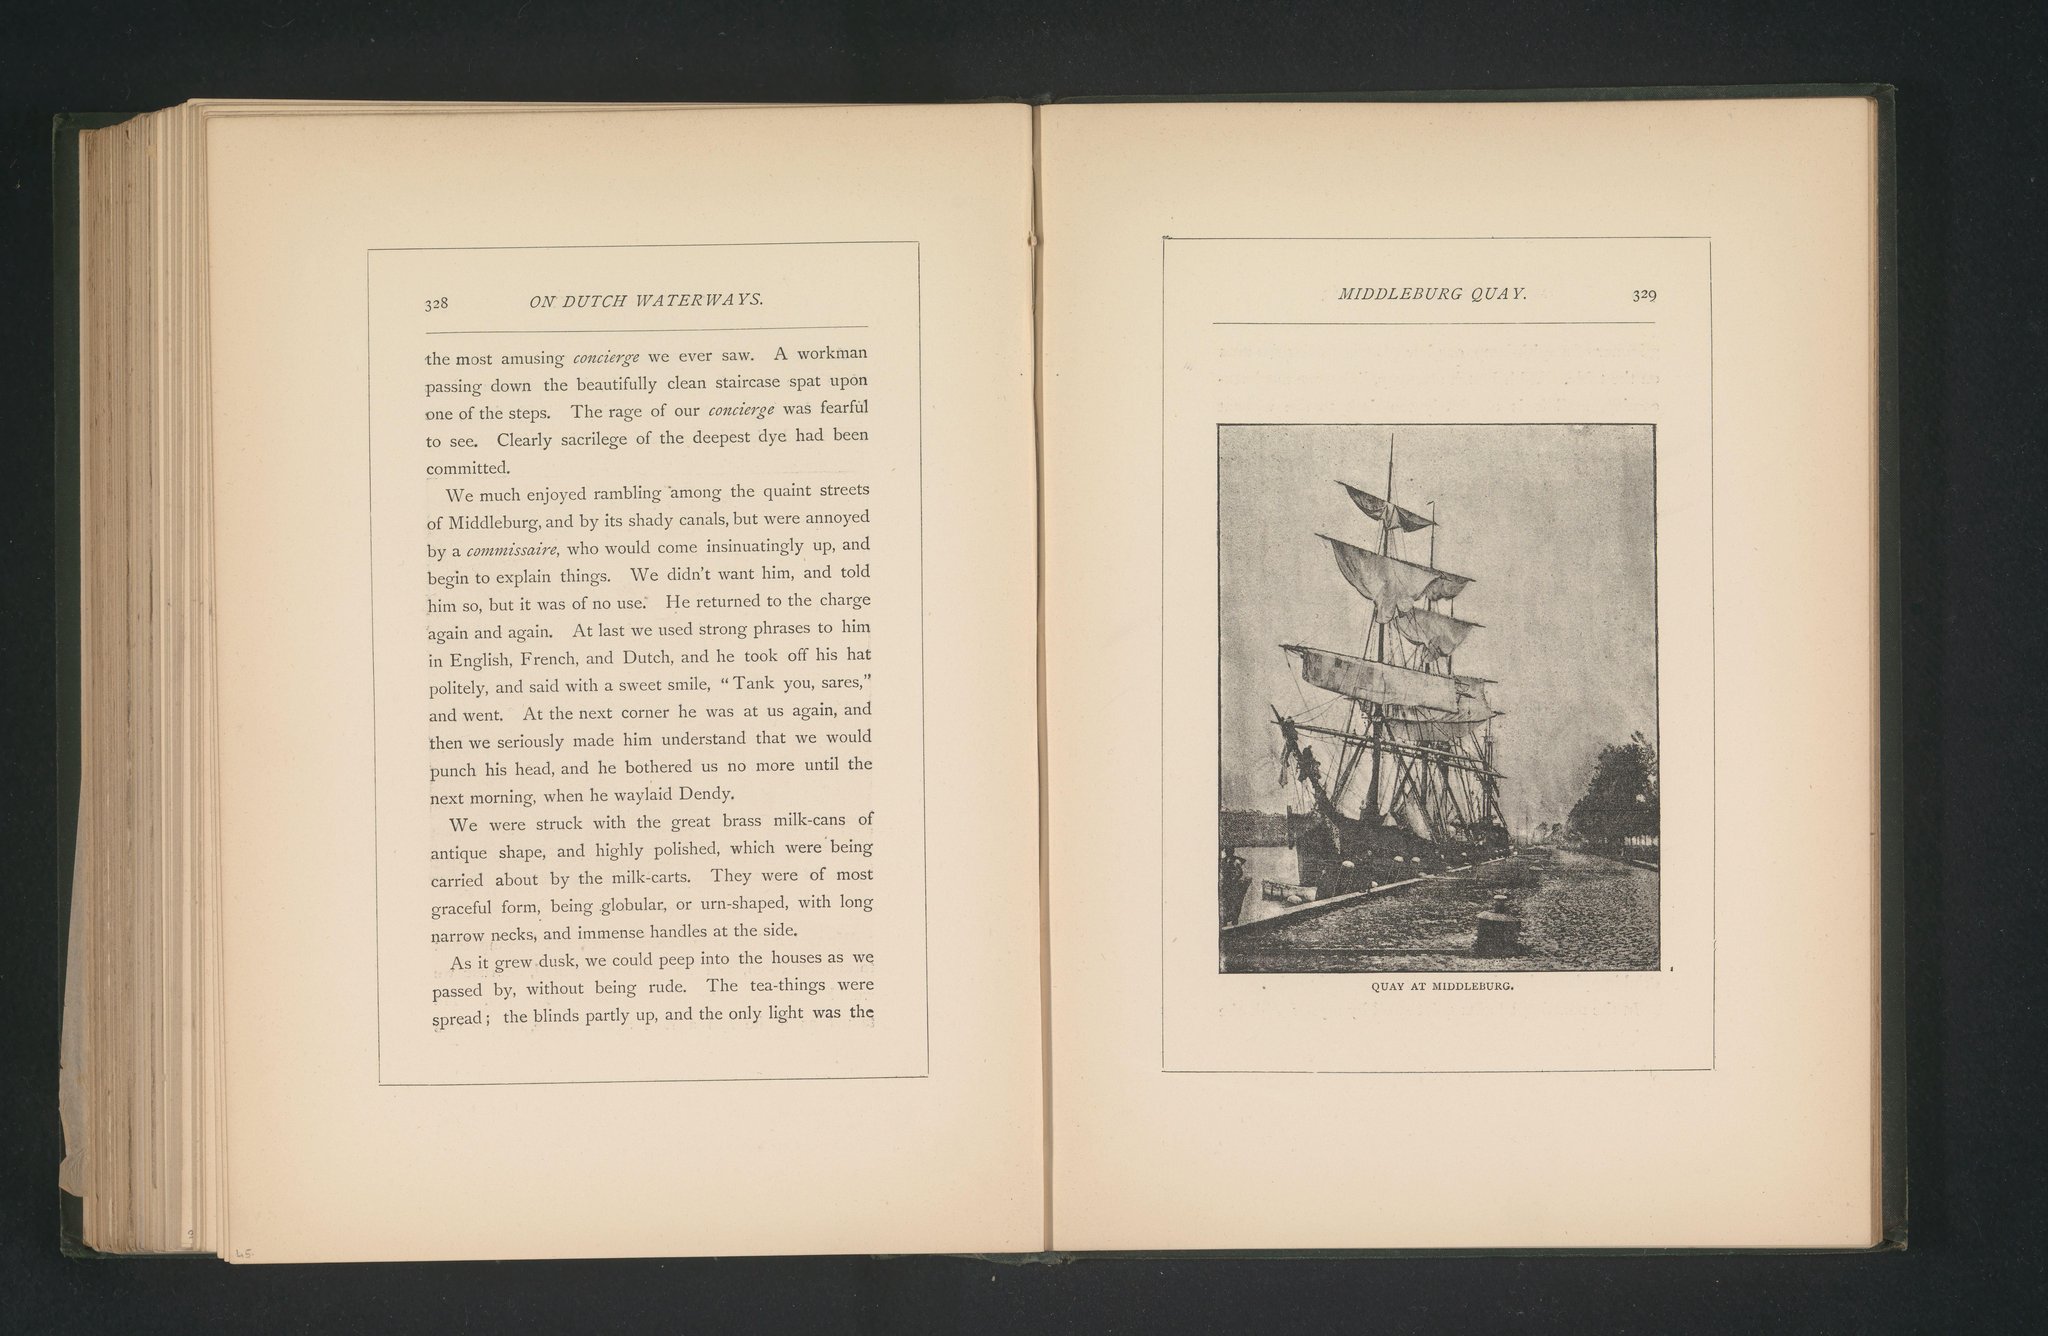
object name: photomechanical print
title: Quay at Middelburg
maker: george christopher davies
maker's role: fotograaf, geoloog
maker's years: 1849-1922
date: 1881-1886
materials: paper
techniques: autotype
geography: middelburg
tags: sailing-ship, sailing-boat, pier, quay, wharf, middelburg